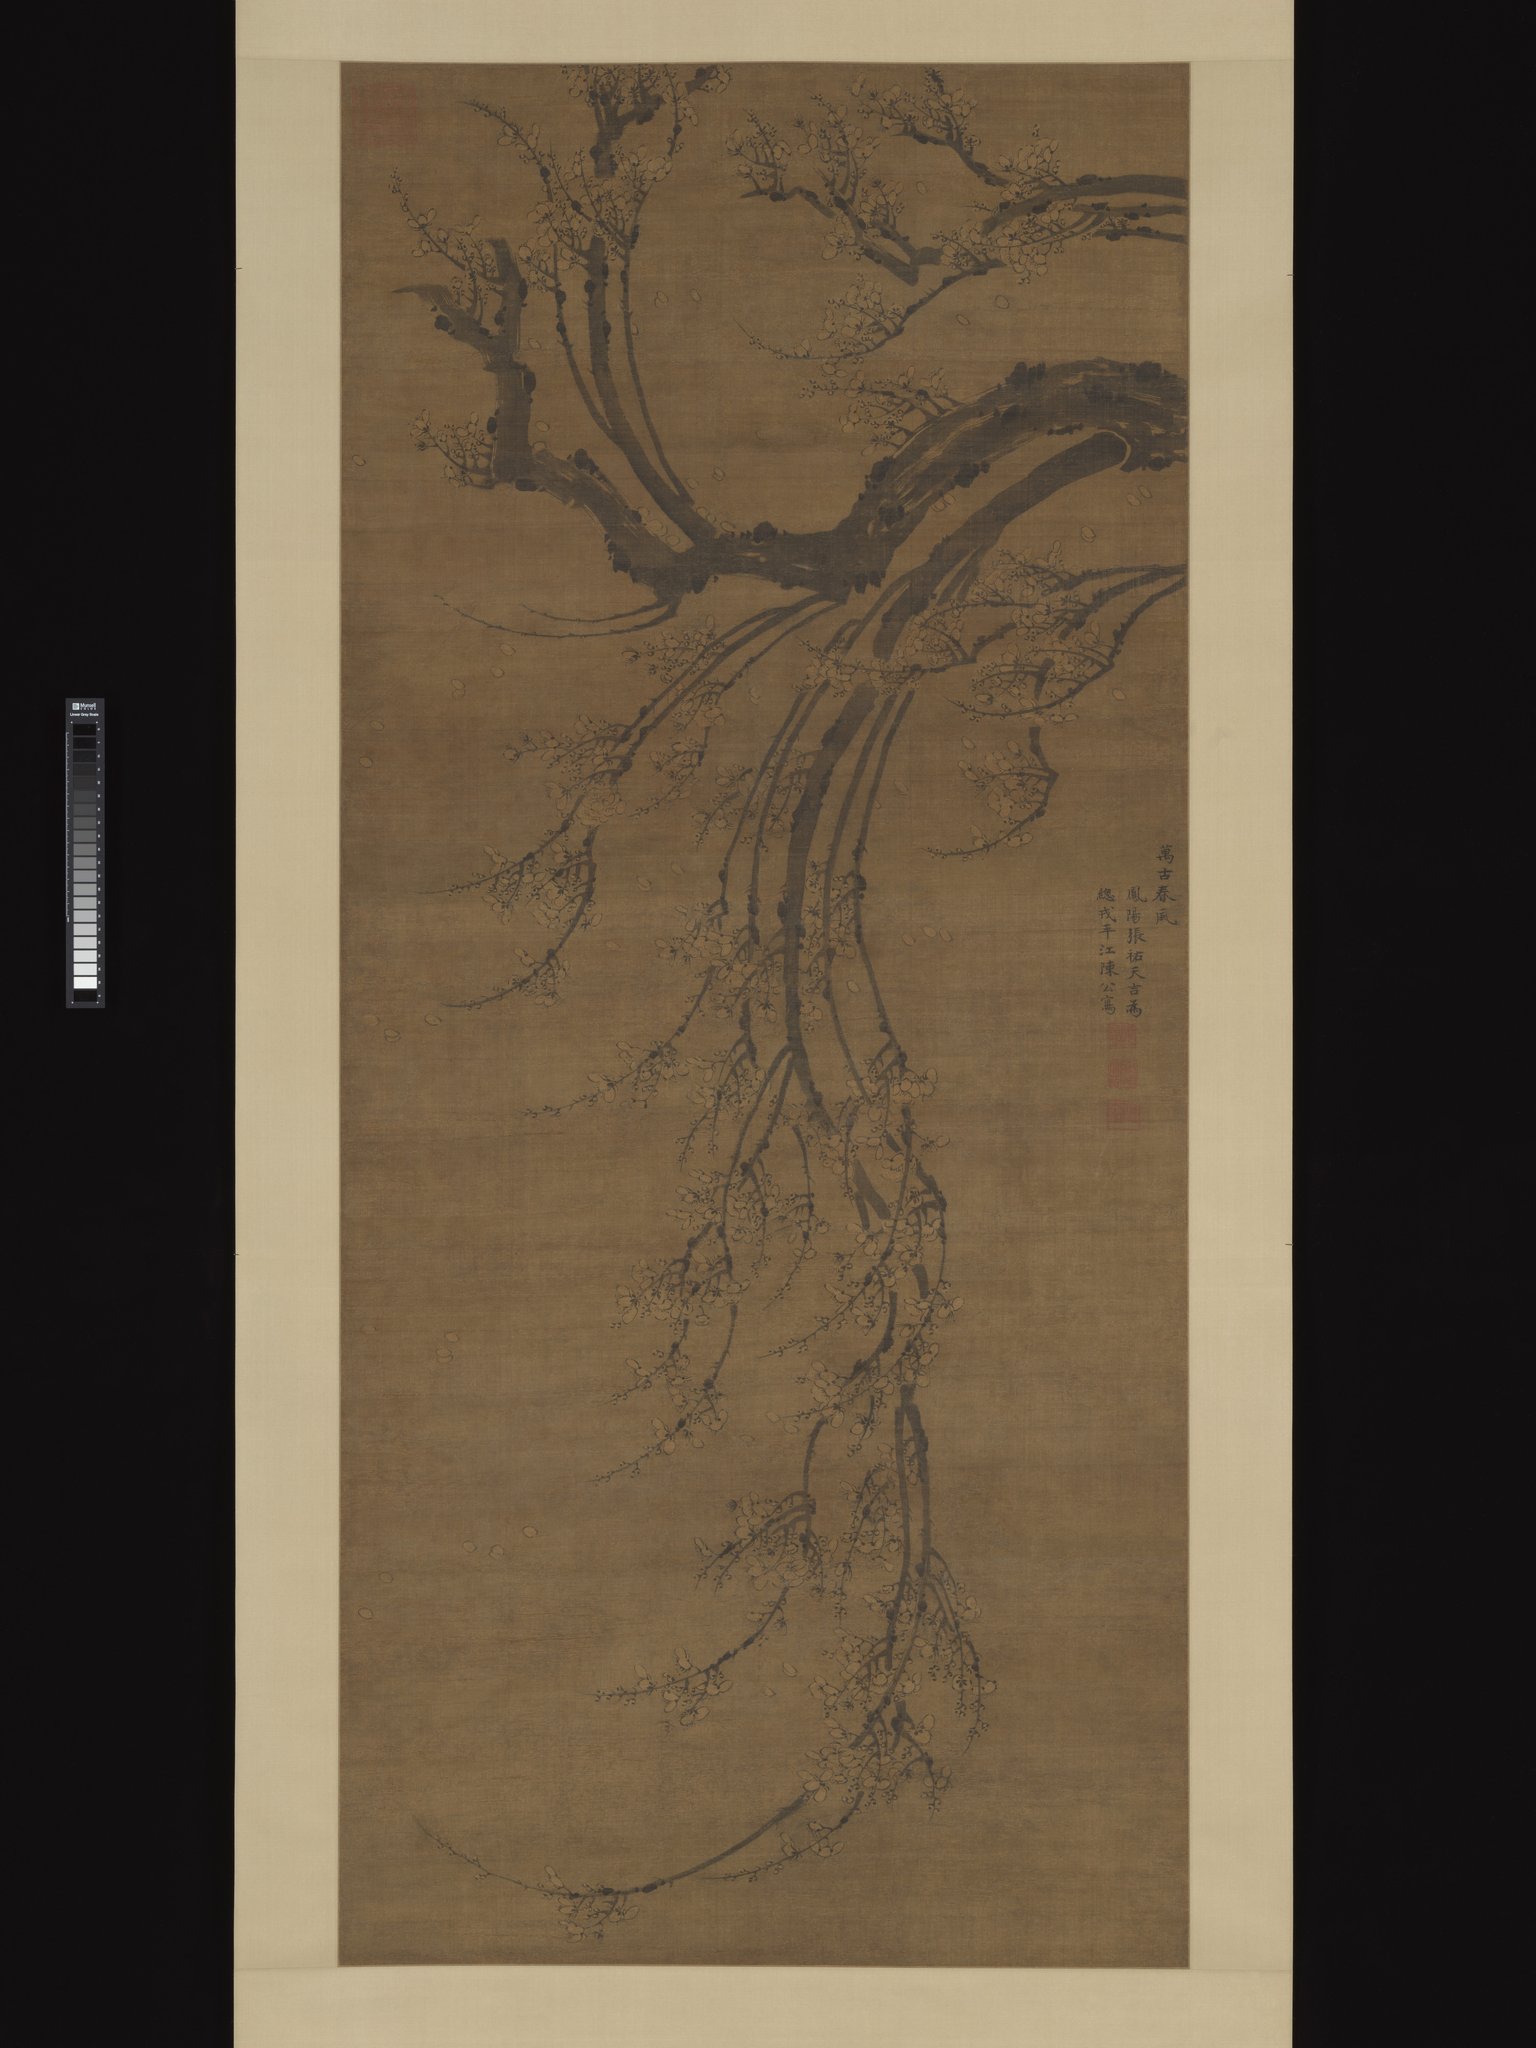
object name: hanging scroll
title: Spring Breeze of Myriad Pasts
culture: chinese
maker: zhang you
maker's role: artist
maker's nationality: chinese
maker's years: 1400-1499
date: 1434-1466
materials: ink, silk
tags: trees